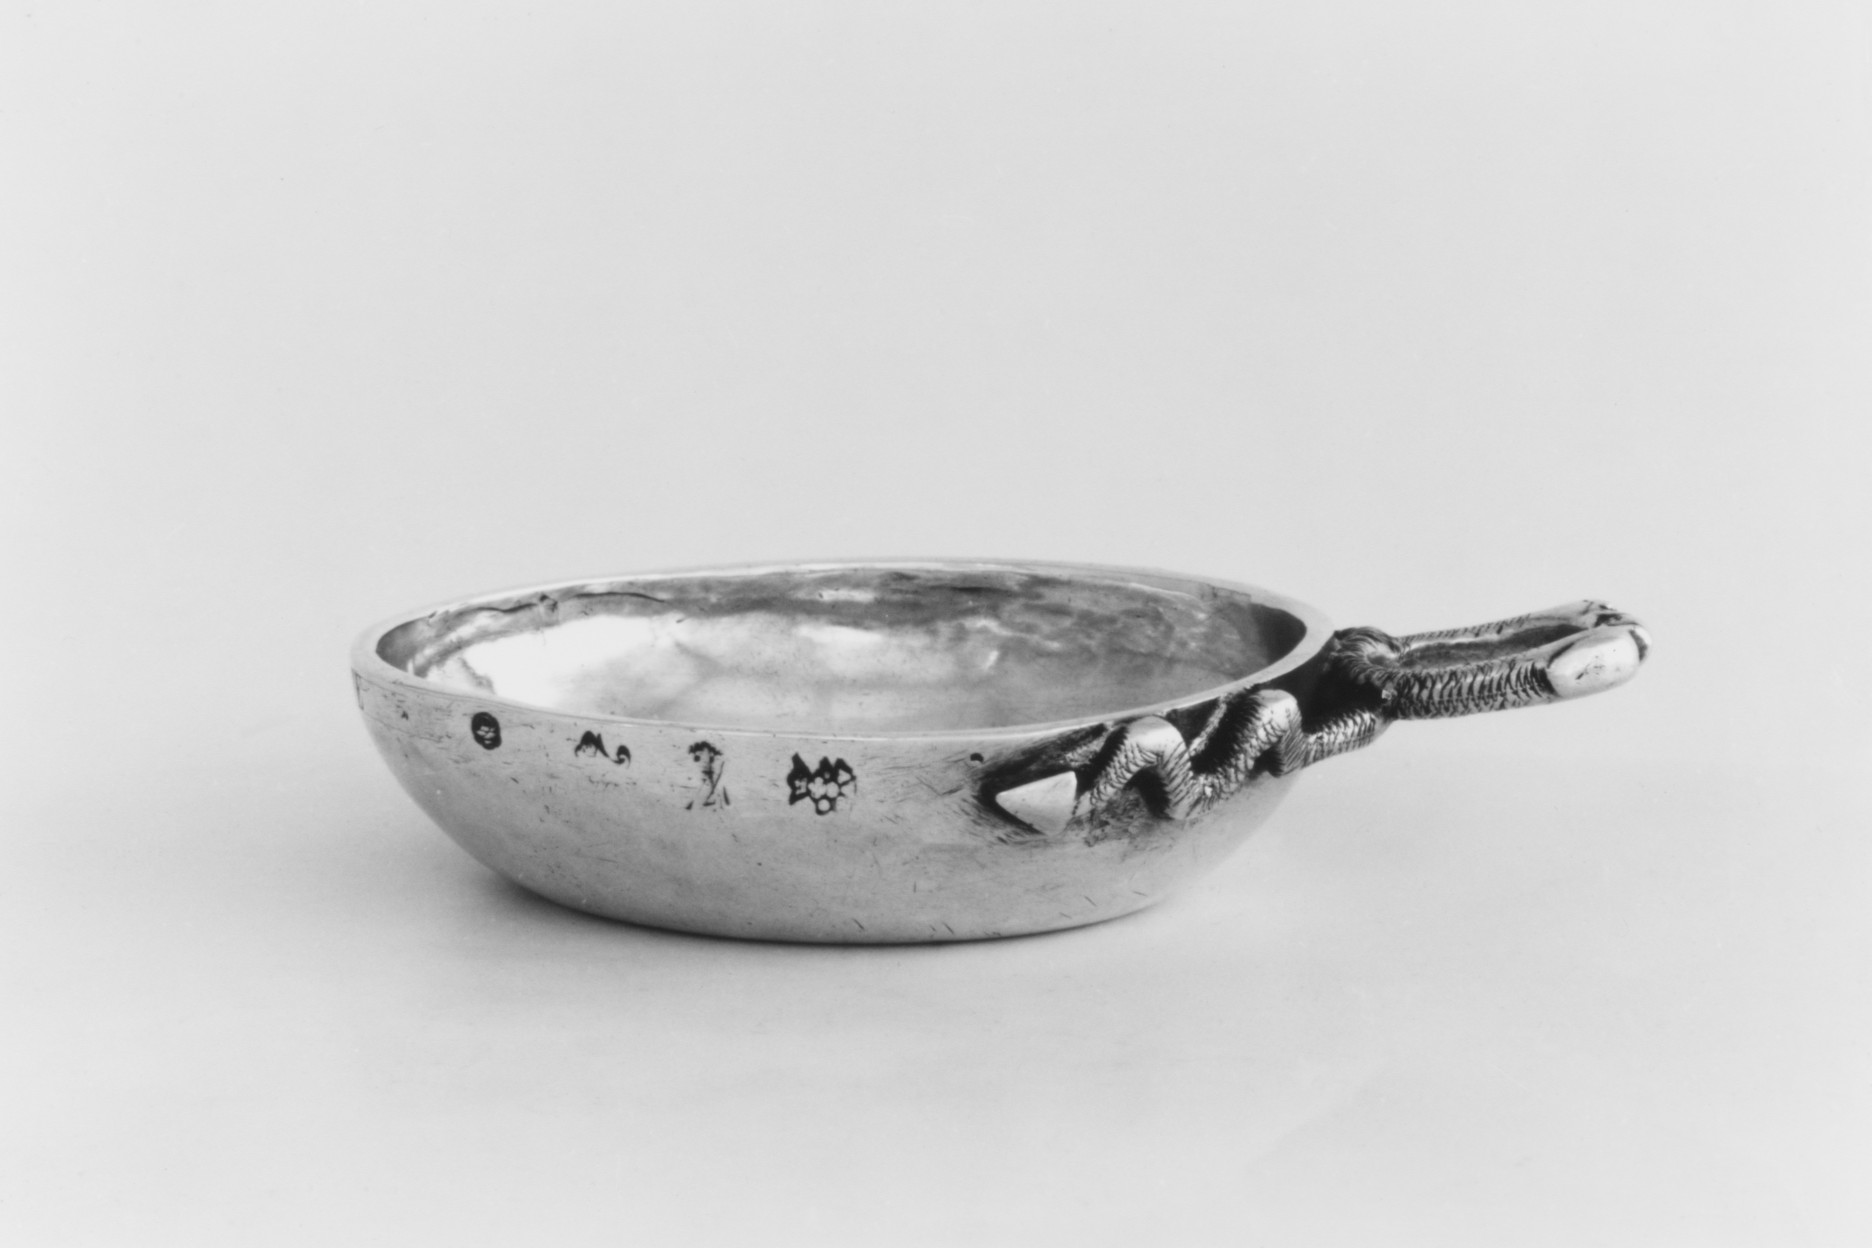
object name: wine taster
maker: pierre antoine viaucourt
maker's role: maker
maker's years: 1699-1799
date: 1763-1764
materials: silver